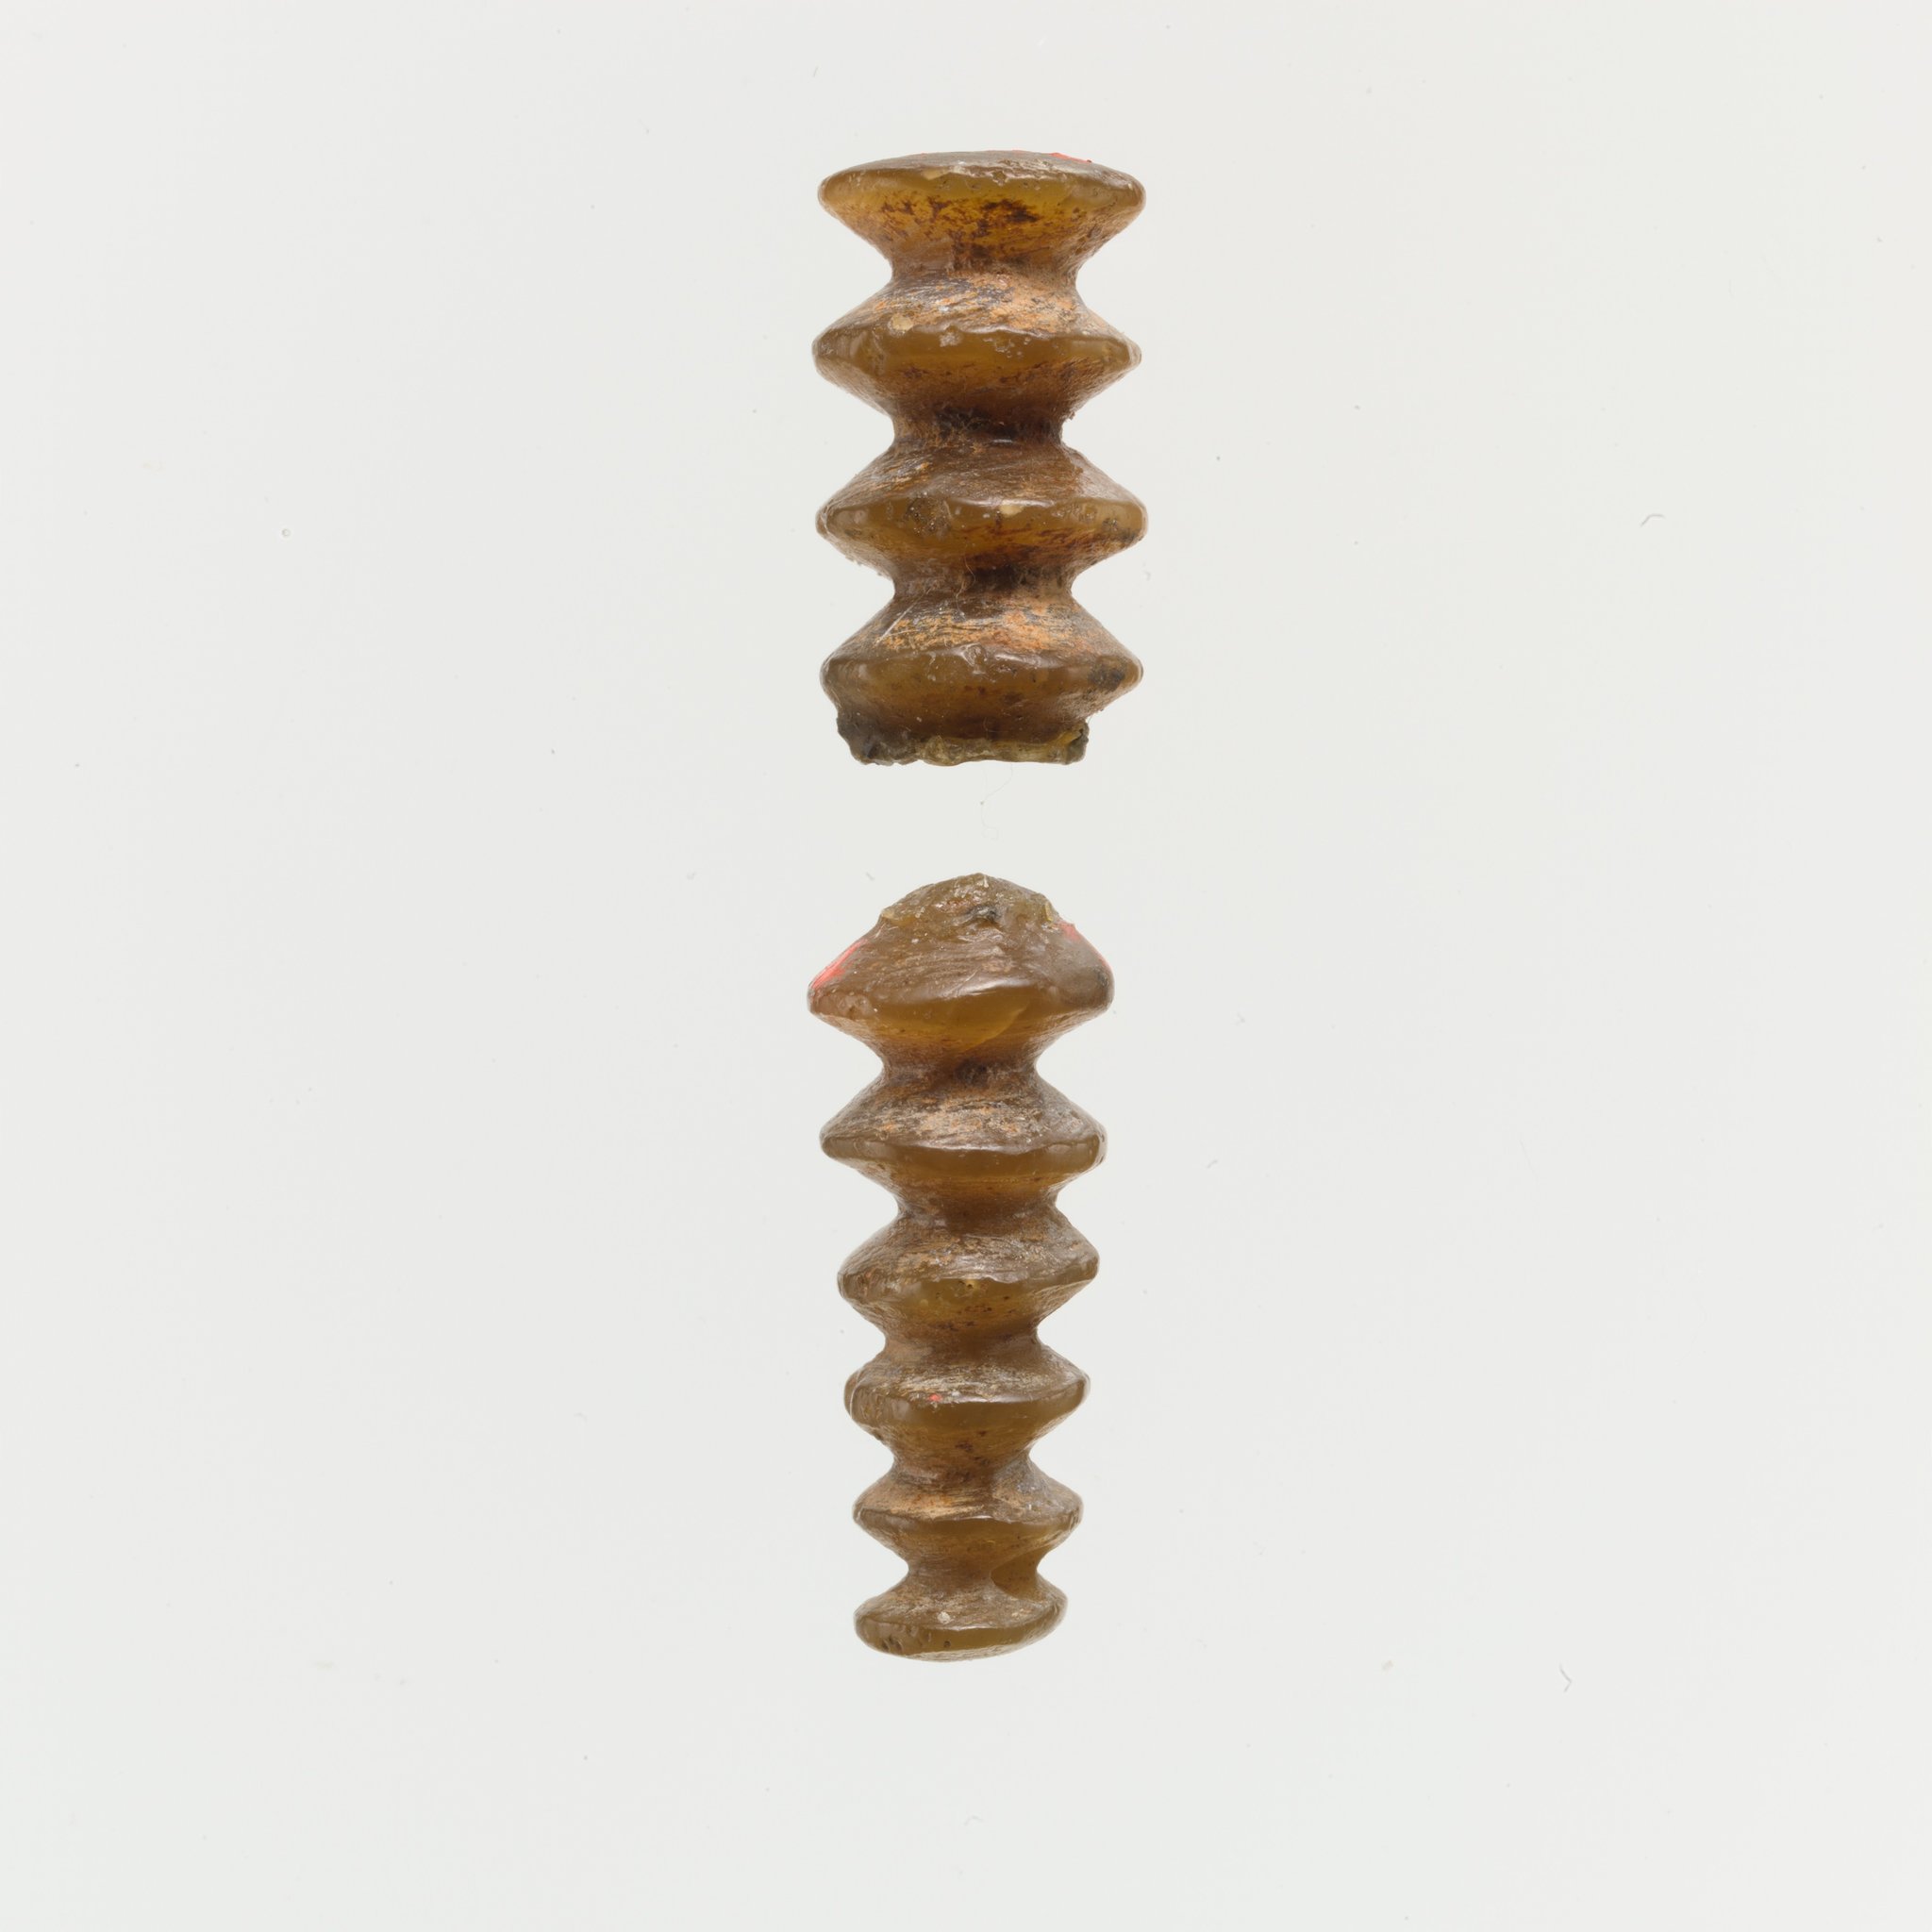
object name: pendant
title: Serpentine (?) pendant fragments with transverse grooves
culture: minoan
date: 3000-1668 BCE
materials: stone